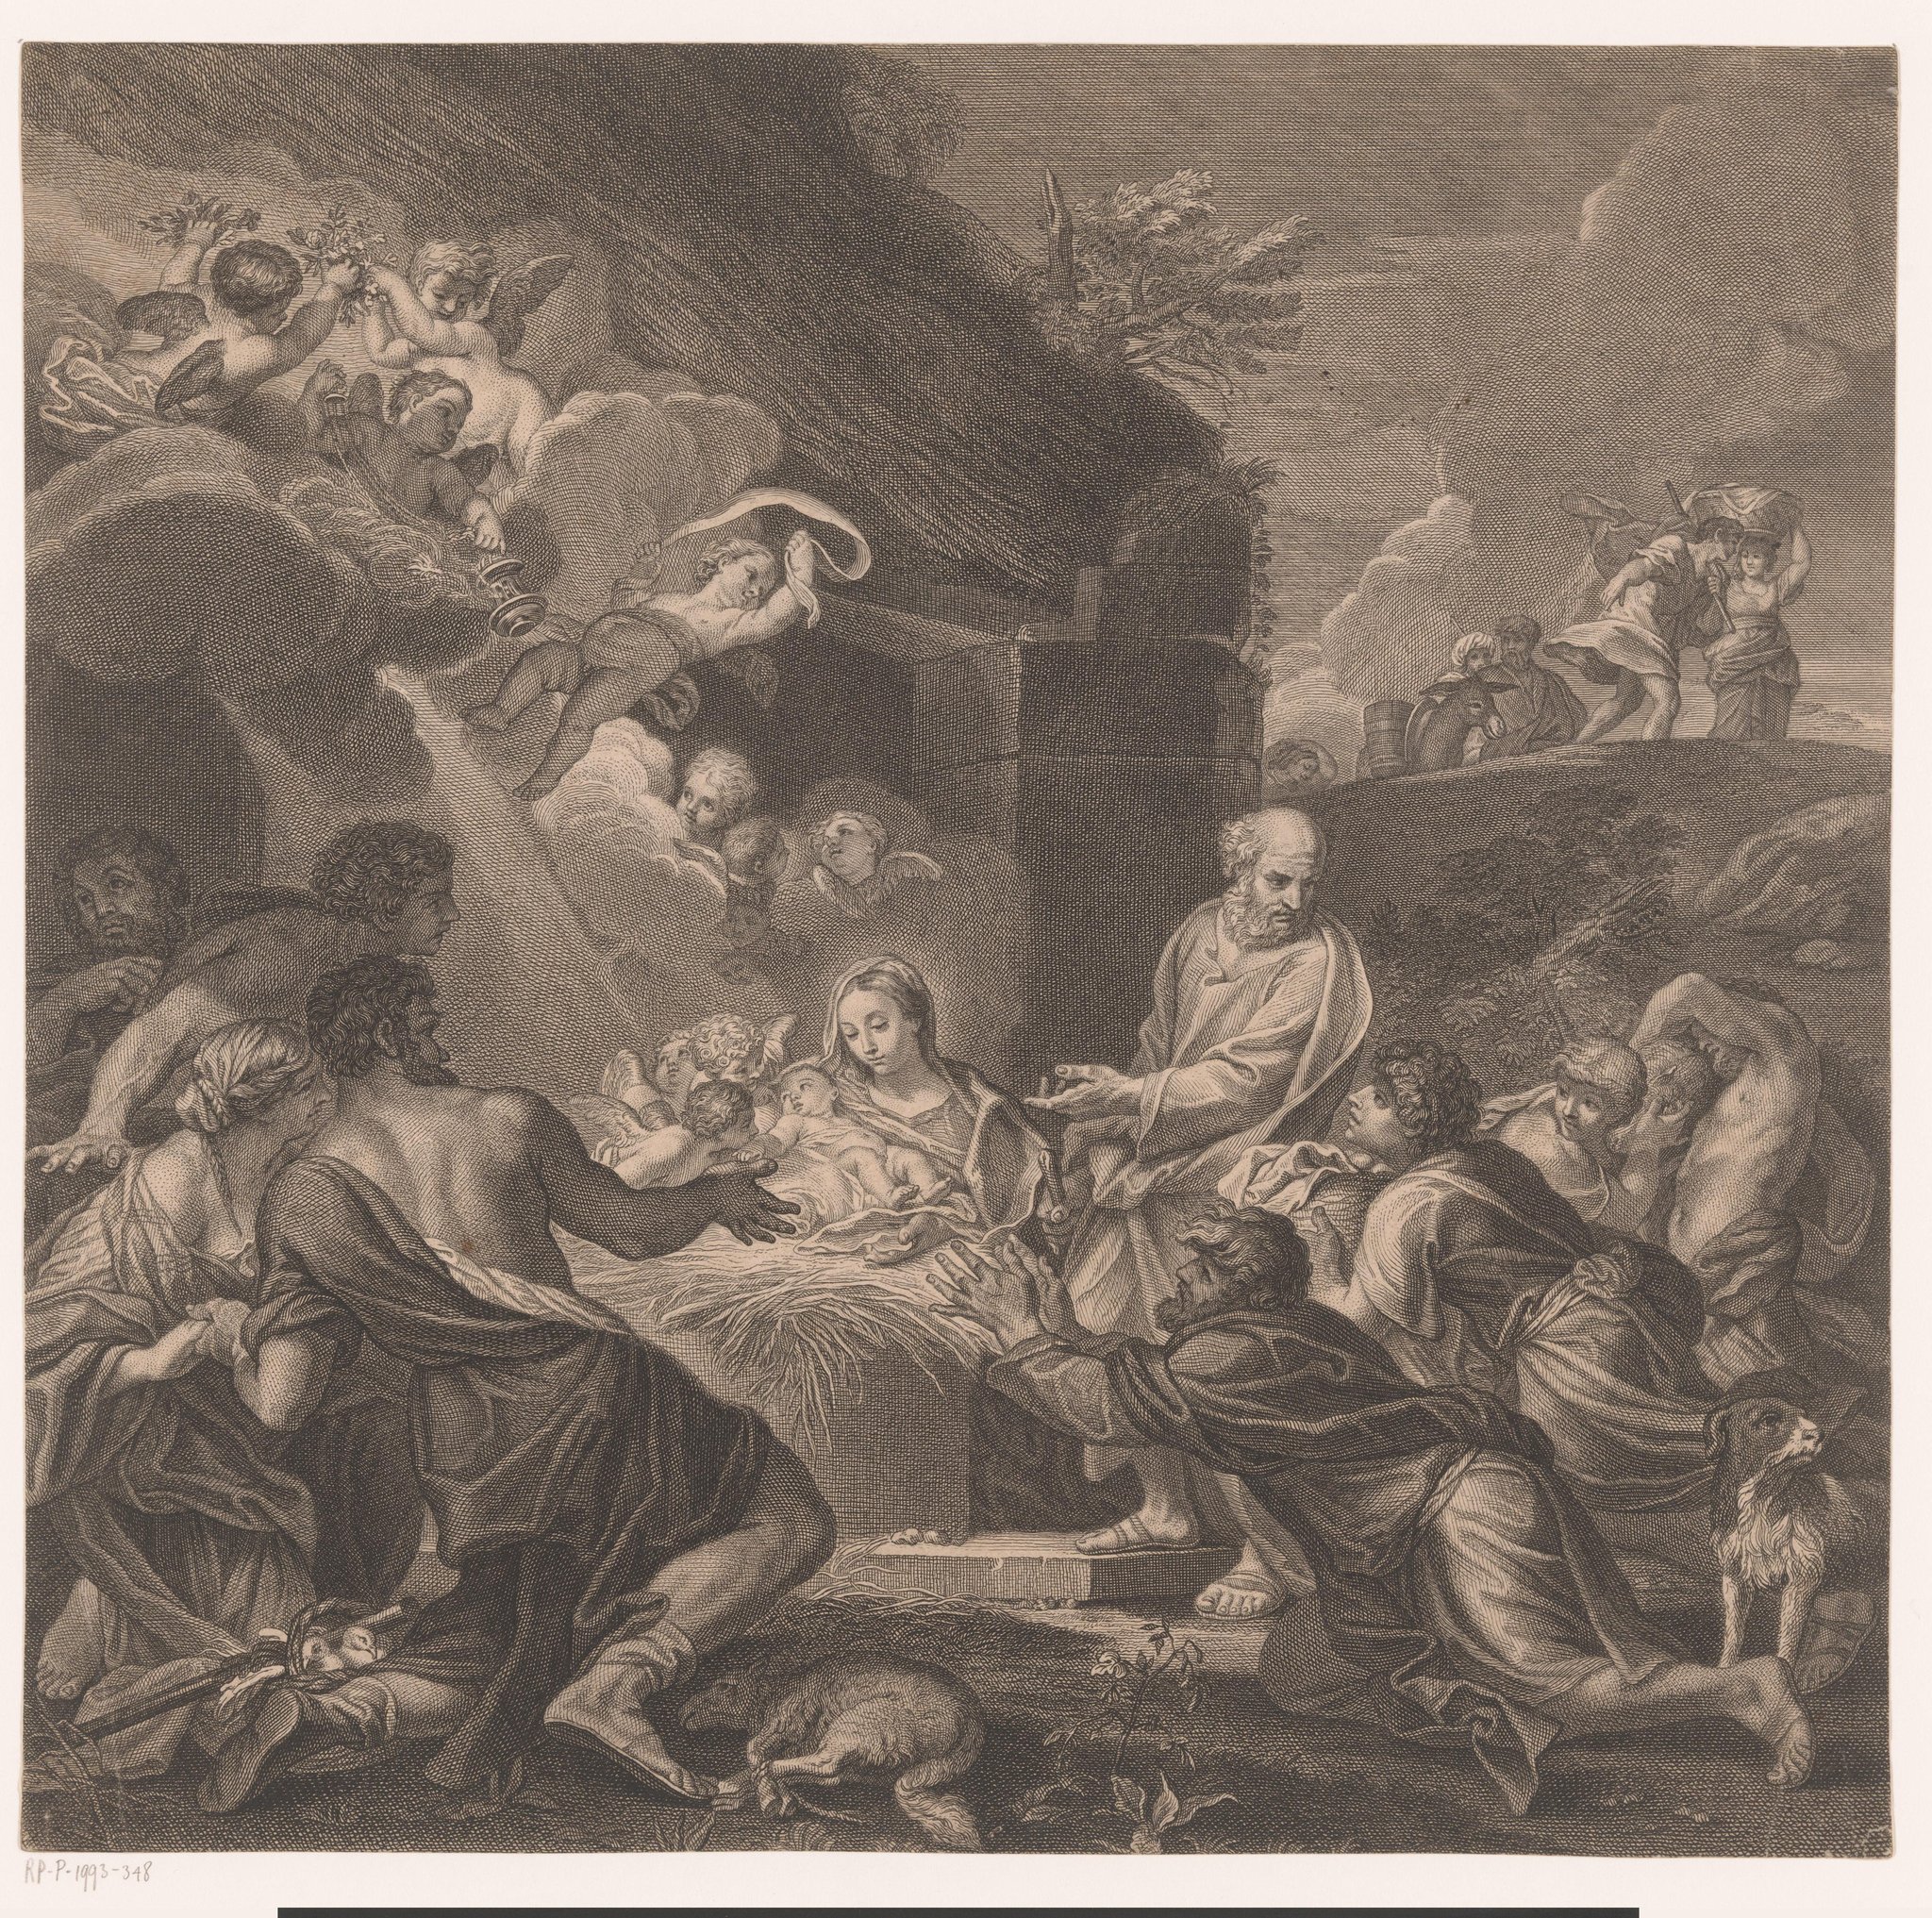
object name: print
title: Cabinet Crozat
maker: jean baptiste de poilly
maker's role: print maker, publisher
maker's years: 1669-1728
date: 1679-1728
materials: paper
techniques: engraving, etching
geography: france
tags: adoration of the christ-child by the shepherds; mary and joseph present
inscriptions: collector's mark: Lugt 2228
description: Rechtsonder genummerd: 121 (hier afgesneden).